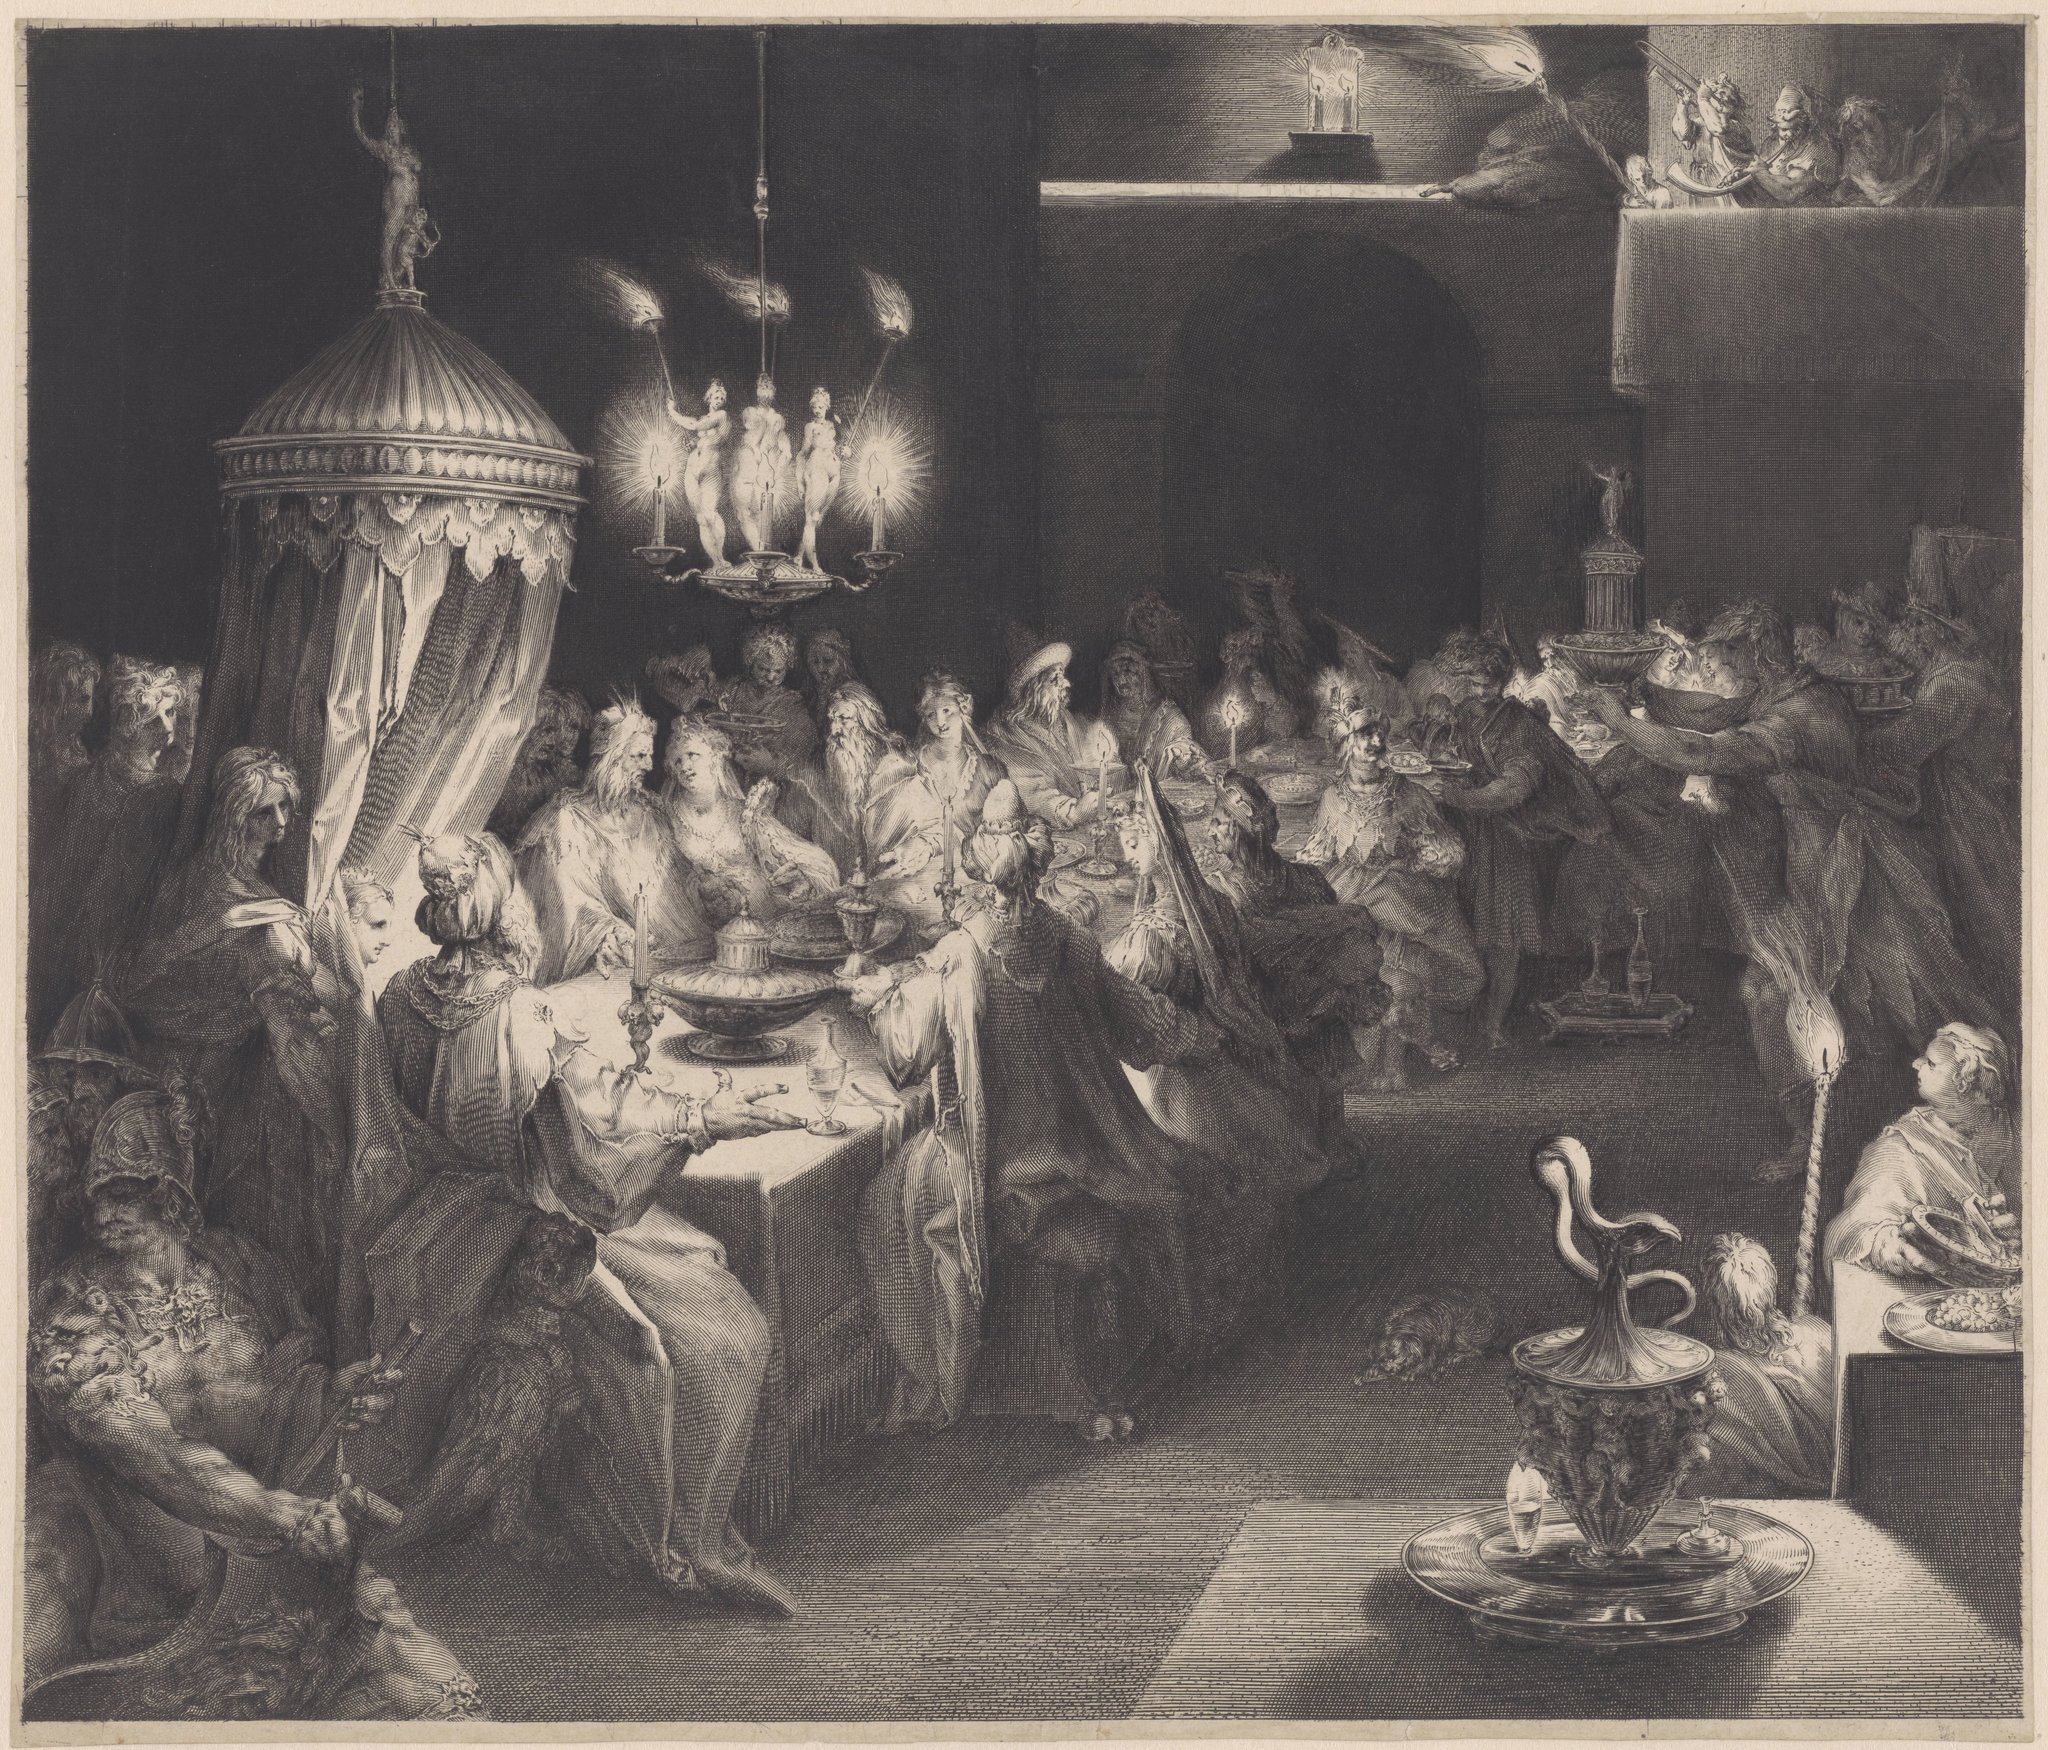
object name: print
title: Feestmaal van Belsassar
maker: jan harmensz. muller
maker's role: draughtsman, print maker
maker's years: 1571-1628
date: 1596-1600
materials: paper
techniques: engraving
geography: amsterdam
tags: during belshazzar's banquet a hand appears and writes on the wall (mene, mene, tekel and parsin (upharsin)); king belshazzar is frightened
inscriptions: collector's mark: Lugt 2228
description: Het feestmaal van Belsassar, koning van Babylon, met zijn hovelingen en vrouwen. Belsassar, op de rug gezien, schrikt van de hand die voor de muur boven de poort verschijnt. Op tafel staan de gestolen bekers en schalen uit de tempel van Jeruzalem.